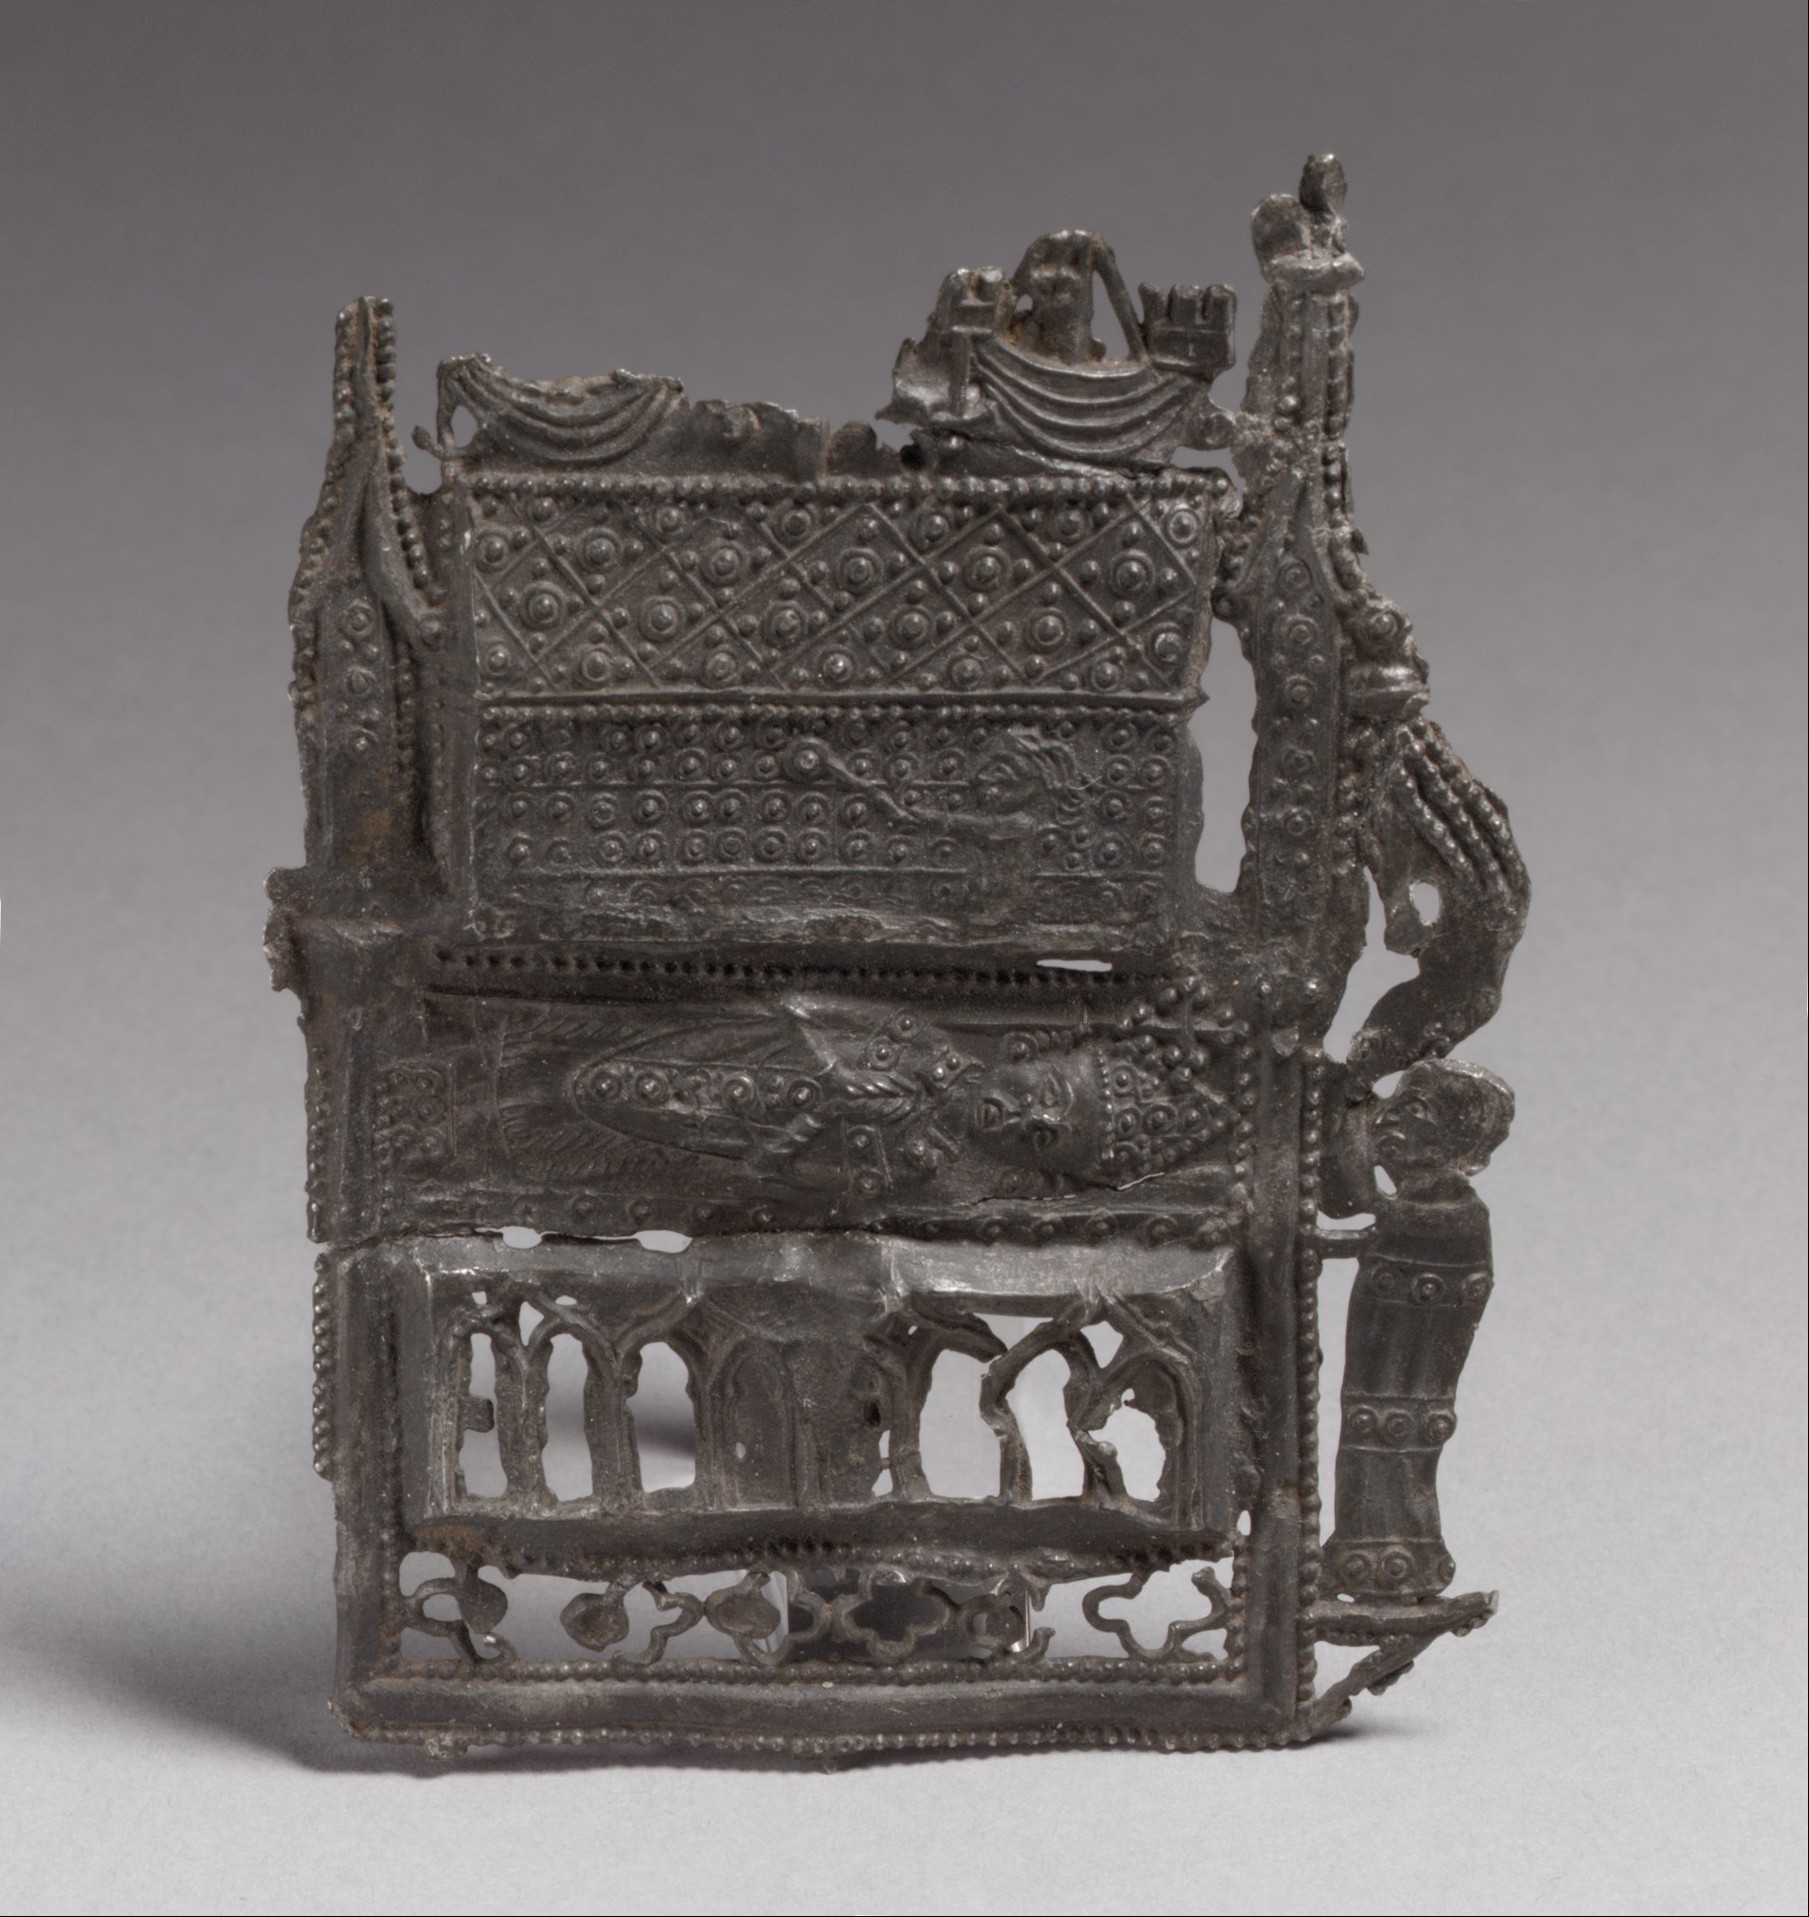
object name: pilgrim's badge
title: Pilgrim's Badge of the Shrine of St. Thomas Becket at Canterbury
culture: british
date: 1350-1400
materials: alloy, lead, tin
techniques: casting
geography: england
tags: tombs,men,saints